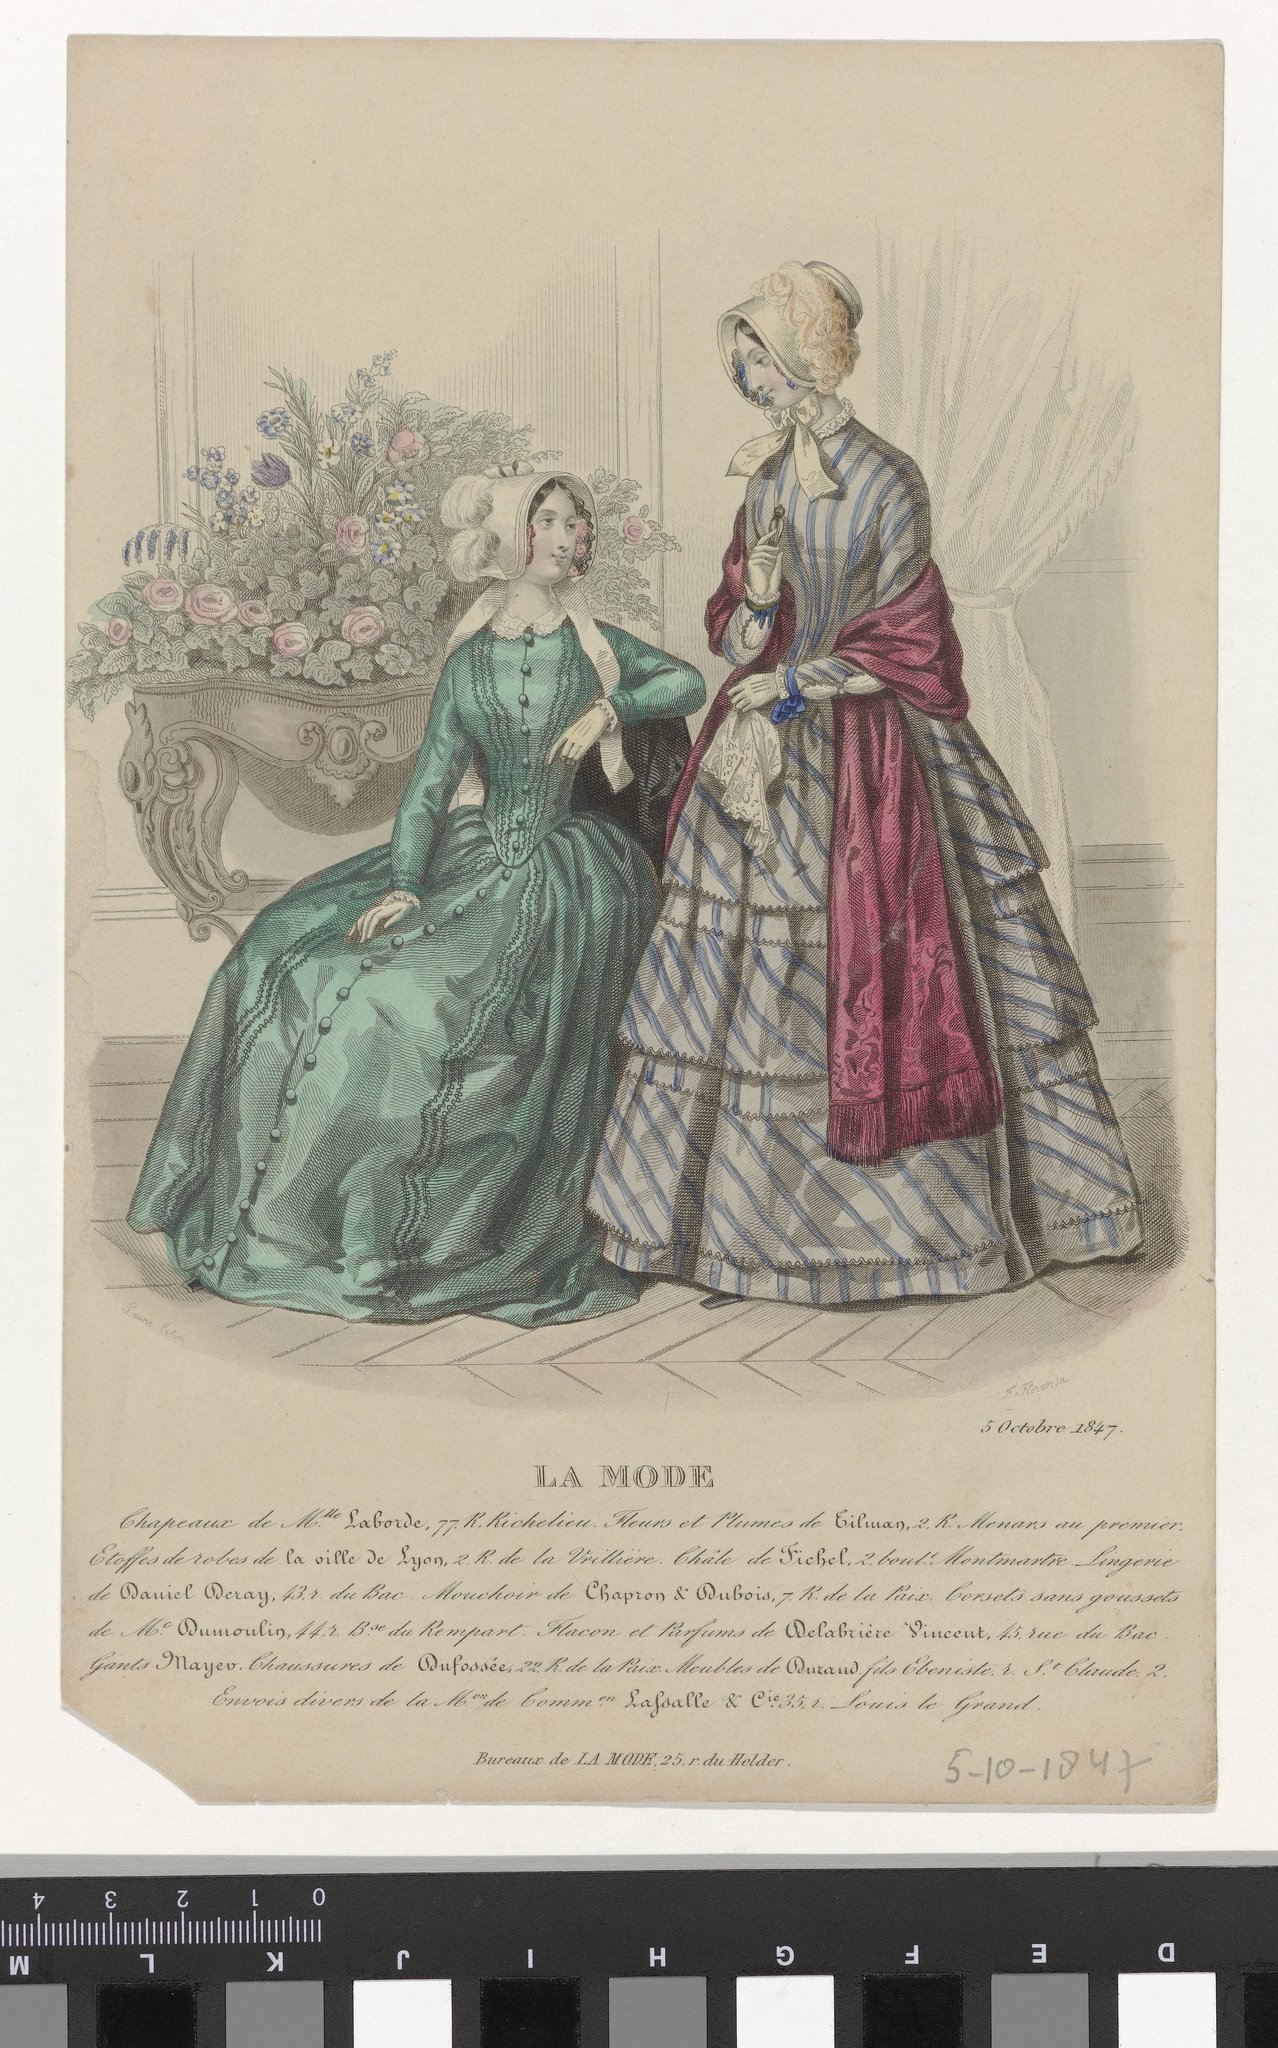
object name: fashion print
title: La Mode, 5 octobre 1847 : Chapeau de M.lle Labord (...)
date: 1847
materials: paper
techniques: engraving, hand coloring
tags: flowers, clothing for the upper part of the body (shawl) (+ women's clothes), perfume bottle - aa - (for) women, fashion plates, head-gear: hat (+ women's clothes), shoes, sandals (+ women's clothes), gloves, mittens, etc. (+ women's clothes), dress, gown (+ women's clothes), fan (+ women's clothes), furniture and household effects, neck-gear ~ clothing (+ women's clothes)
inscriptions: address: ‘Bureaux de La Mode, 25, r. du Helder’, caption: ‘Chapeau de M.lle Laborde, 77. R. Richelieu. Fleurs et Plumes de Tilman, 2, R. Menars au premier. Etoffes de robes de la ville de Lyon, 2. R. de la Vrilliére. Châle de Fichel, 2. voul.t Montmartre. Lingerie de Daniel Deray, 43.r. du Bac. Mouchoir de Chapron & Dubois, 7. R. de la Paix. Corsets sans goussets de M.e Dumoulin, 44.r. B.se du Rempart. Flacon et Parfums de Delabrière Vincent, 45. rue du Bac. Gants Mayer. Chaussures de Dufossée, 22. R. de la Paix. Meubles de Durand. fils Ebeniste. r. S.t Claude.2. Envois divers de la M.on de Comm.on Lassalle & C.ie. 35. r. Louis le Grand.’, title: ‘La Mode’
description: Twee vrouwen in een interieur. Volgens het onderschrift: hoeden van Laborde. Bloemen en veren van Tilman. Stoffen van de japonnen van 'ville de Lyon'. Sjaal van Fichel. Hieronder enkele regels reclametekst voor verschillende producten. Prent uit het modetijdschrift La Mode (1829-1855).